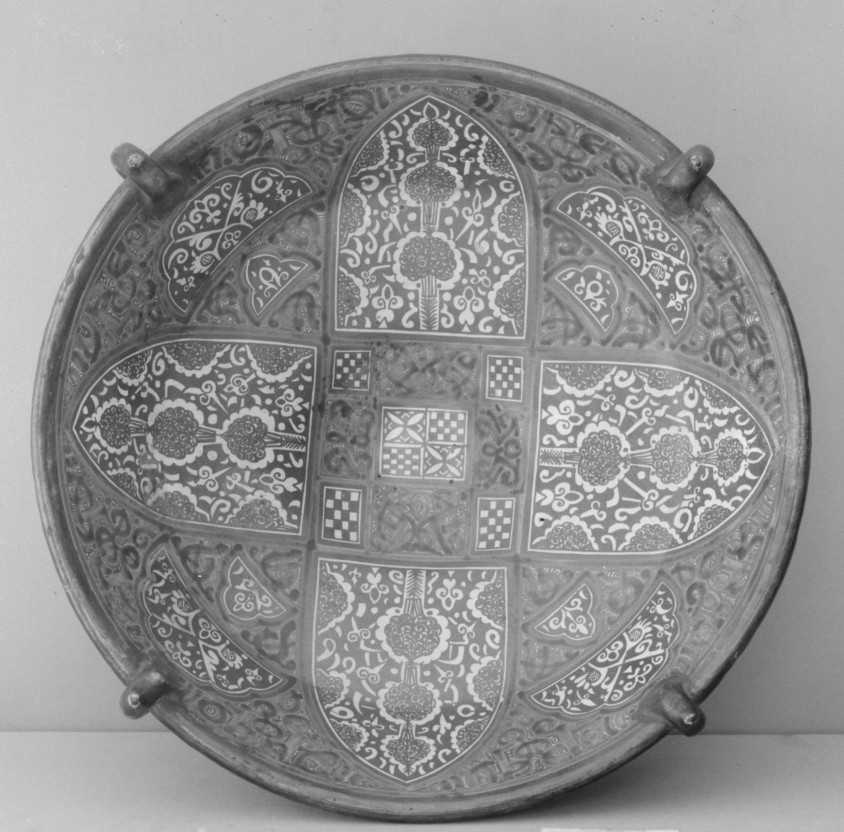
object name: bowl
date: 1801-1900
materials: earthenware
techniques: luster painting, glazing